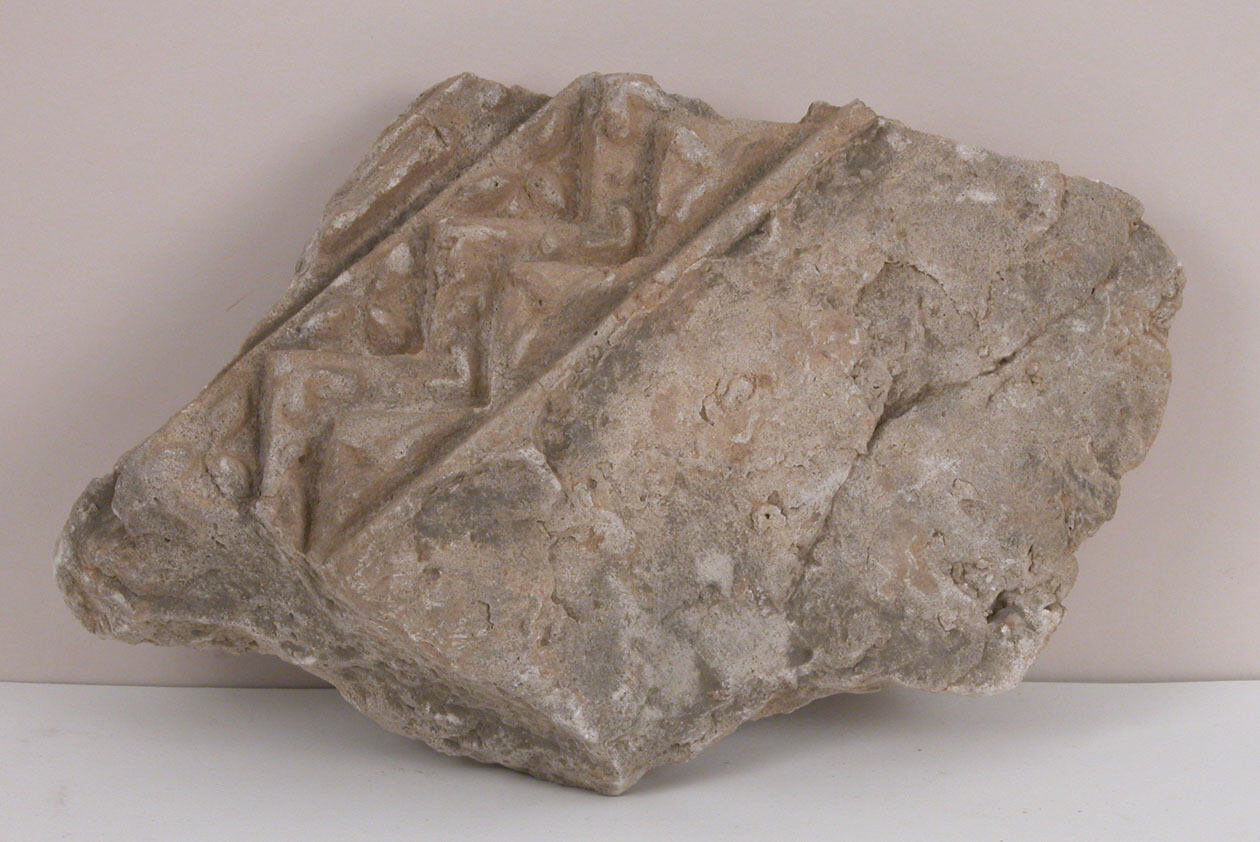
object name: fragment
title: Fragment of a Molding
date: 901-1000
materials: plaster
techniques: molding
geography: iran